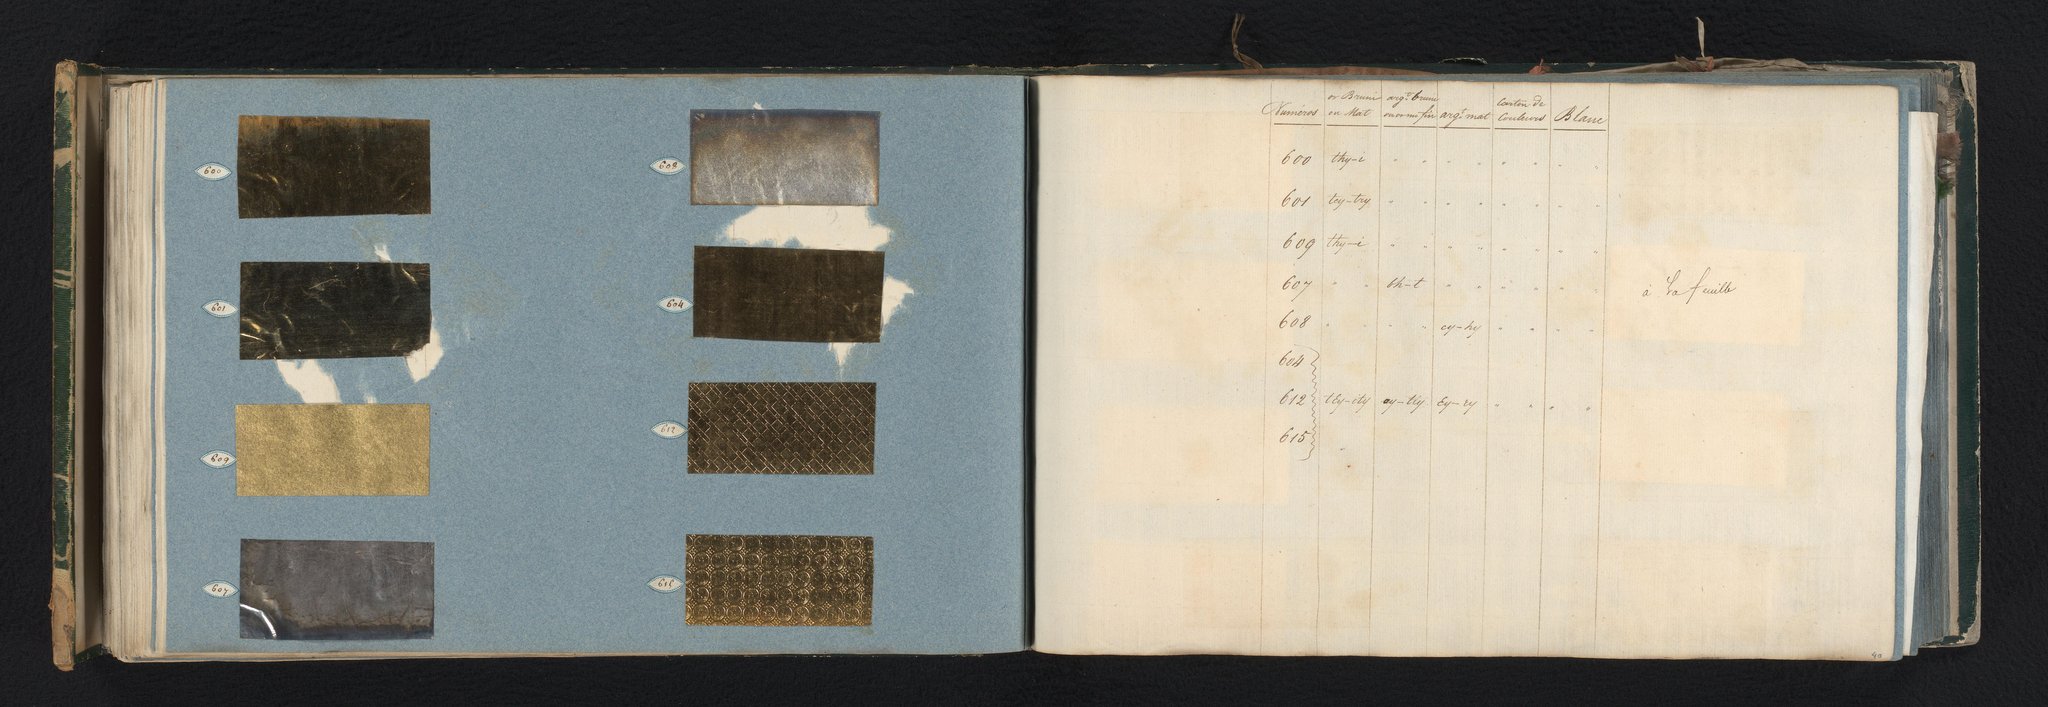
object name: metallic paper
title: Twee bladzijden met stalen van goud- en zilverkleurig metaalpapier en bijbehorend tabel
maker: Anonymous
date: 1830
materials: gold leaf, ink, paper, silver leaf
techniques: writing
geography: france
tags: ornament ~ geometric motifs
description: Twee bladzijden met links 8 opgeplakte en met etiketten genummerde (600-615) stalen van geometrisch gedecoreerde en effen stroken van goud- en zilverkleurig metaalpapier. Op de tegenoverliggende rechterbladzijde een tabel met de handgeschreven corresponderende specificaties (in code) per ornament. Onderdeel van het stalenboek geschonken door de dames Van Rijn, vermoedelijk van een Franse papierfabrikant van luxe papieren, of diens vertegenwoordiger in Nederland, ca. 1830.